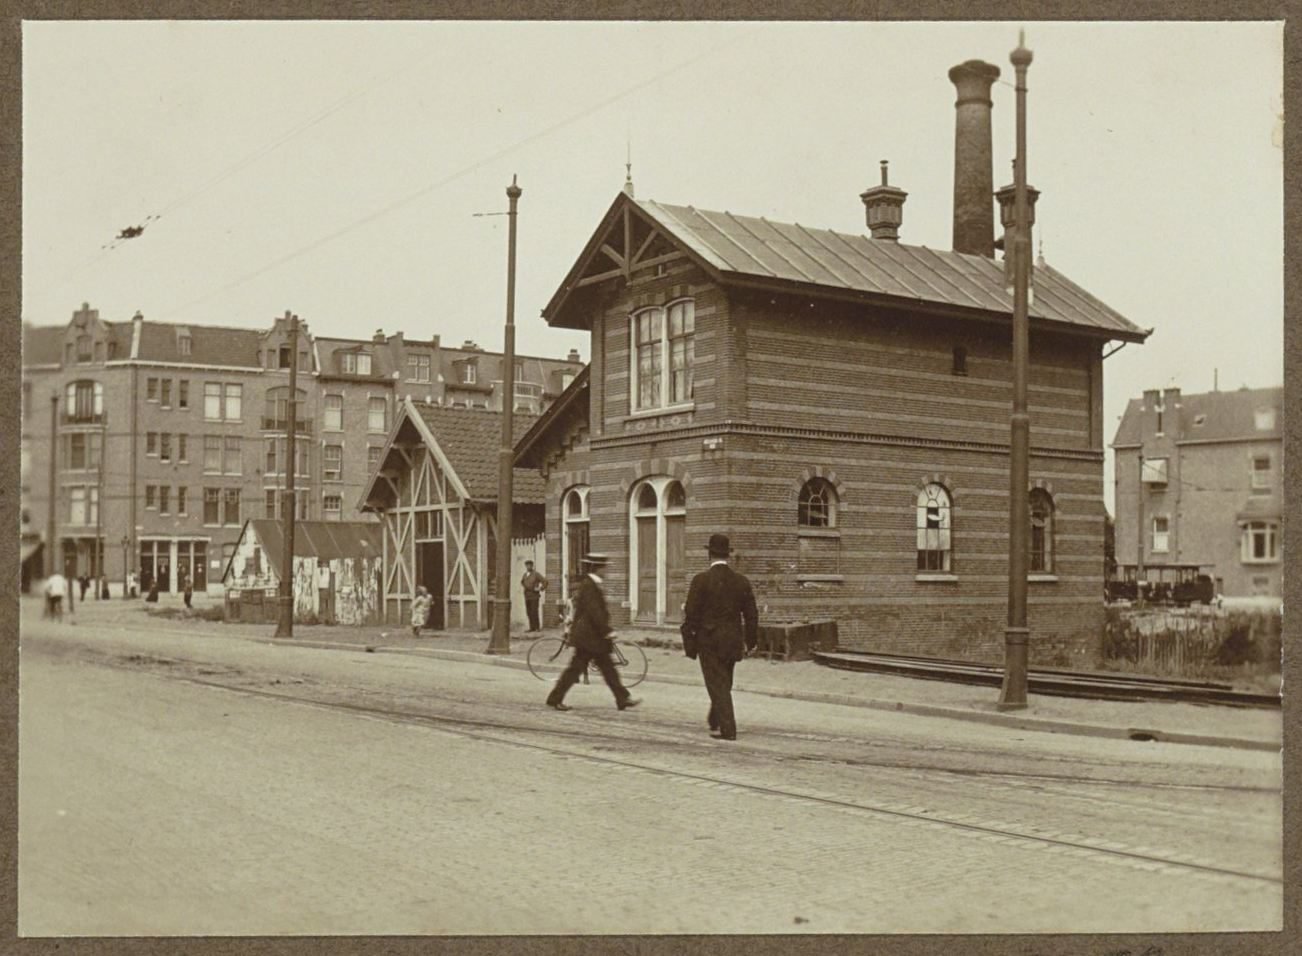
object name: photograph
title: Stoomgemaal voor het Vondelpark en Willemspark aan de Amstelveenseweg te Amsterdam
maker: Anonymous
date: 1910-1930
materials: paper, photographic support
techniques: daylight paper print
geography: amsterdam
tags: pumping installation, pumping-engine (~ polder), amsterdam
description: Onderdeel van Album met foto's van Amsterdam en omgeving.